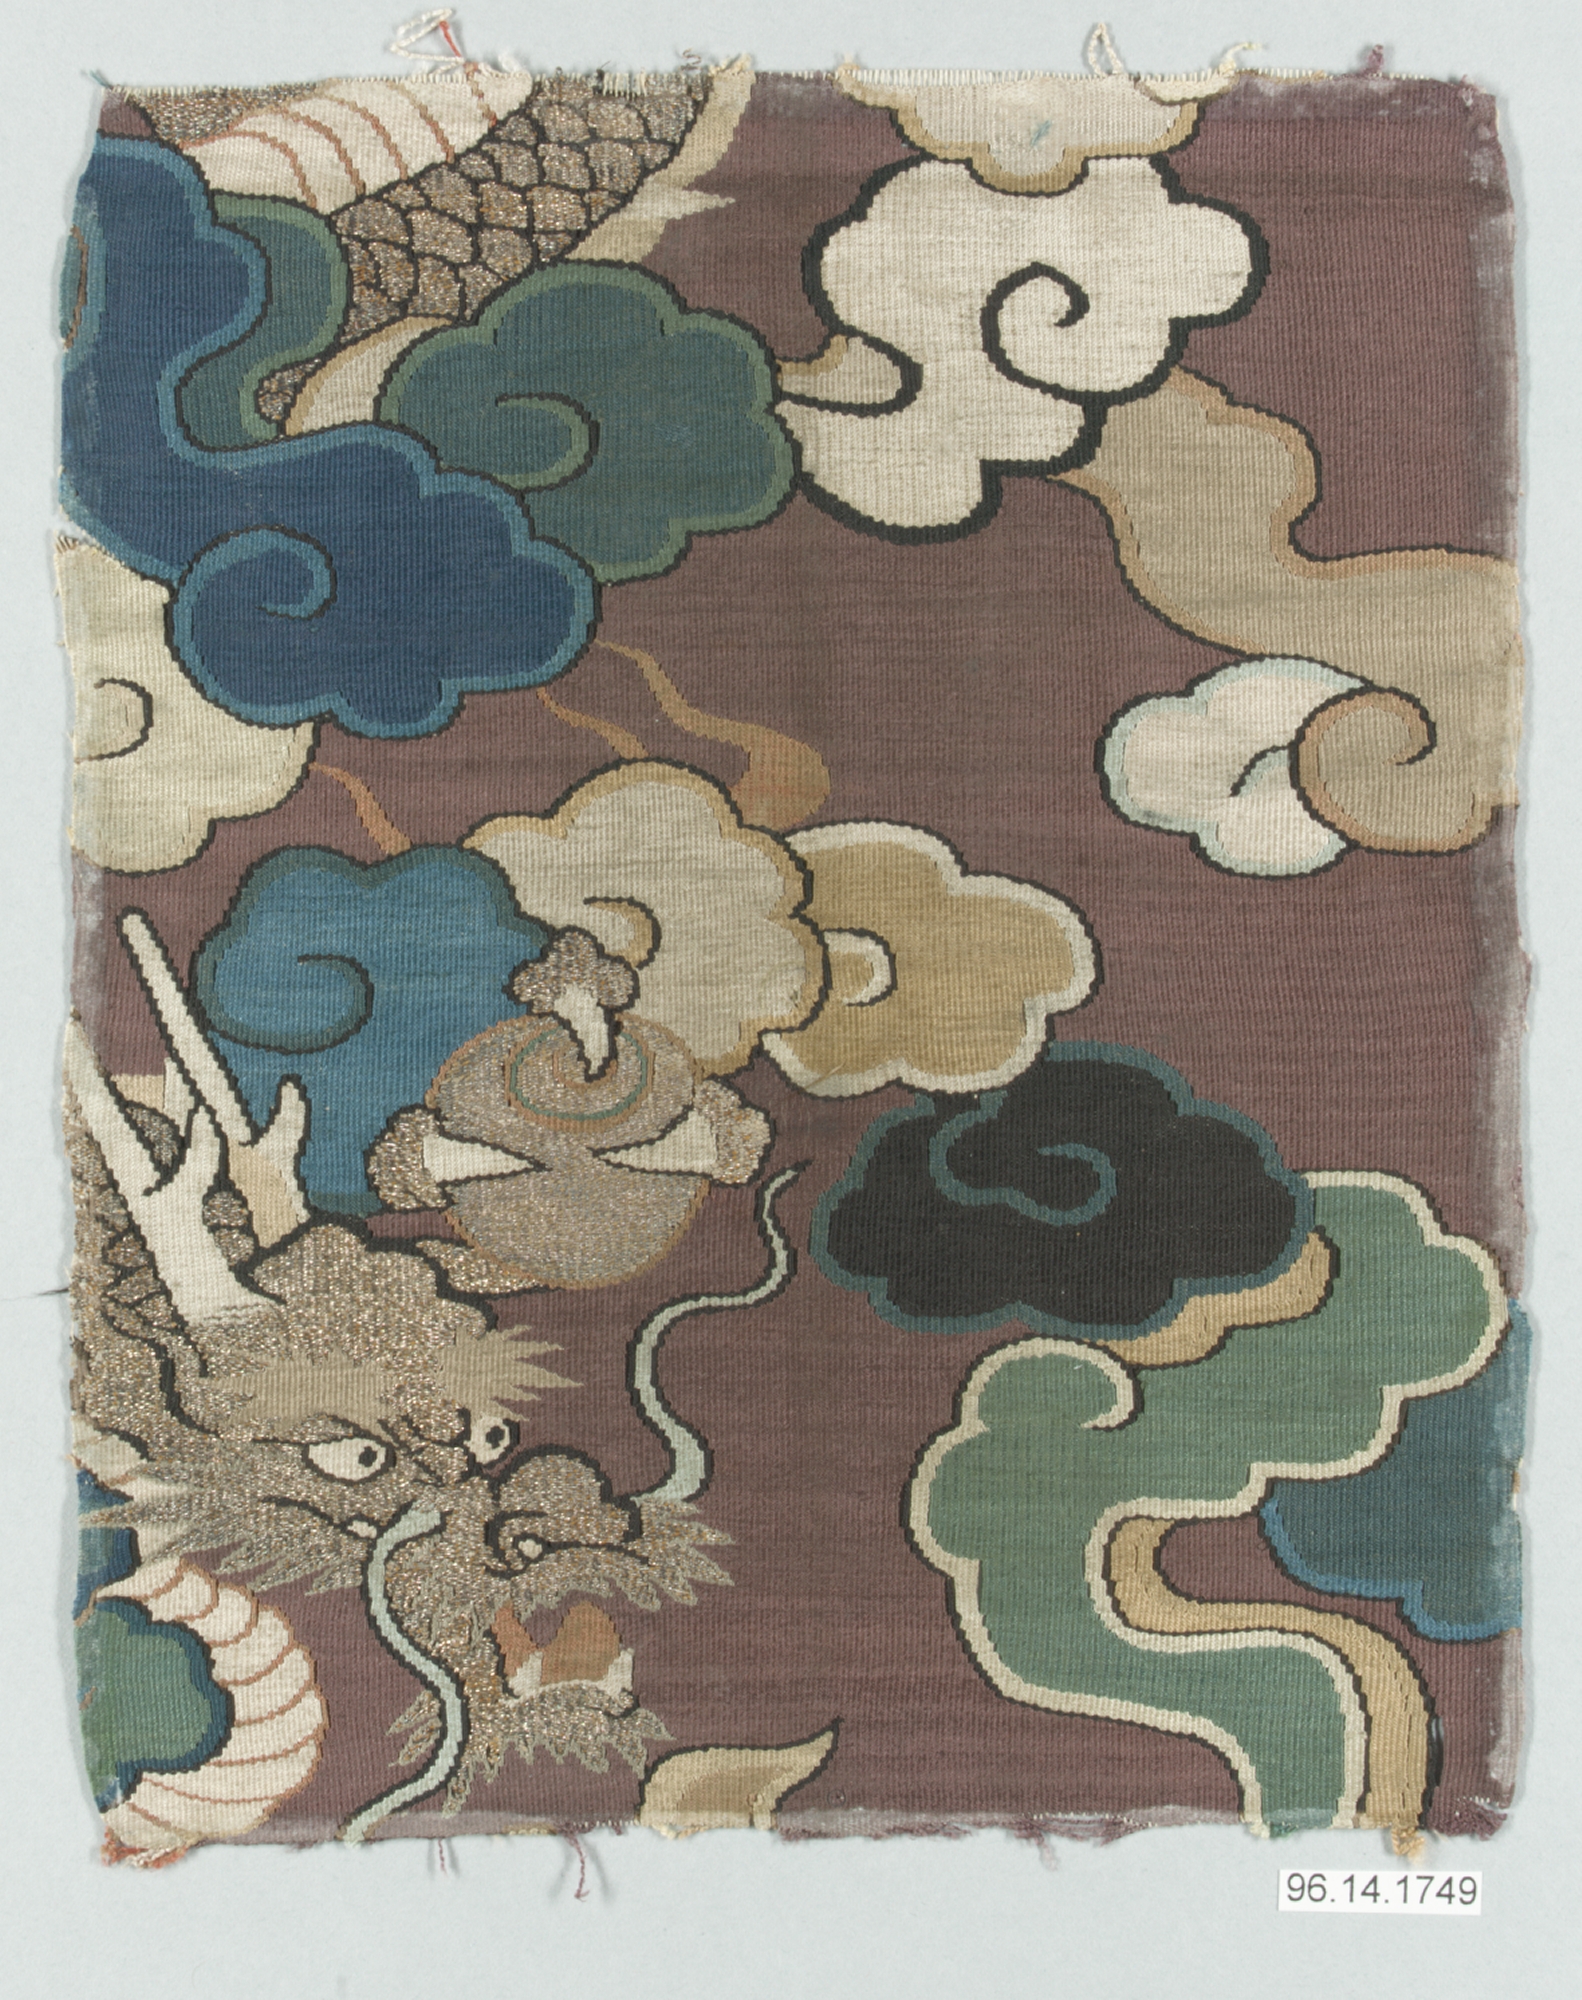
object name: piece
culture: japanese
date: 1701-1900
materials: silk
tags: dragons